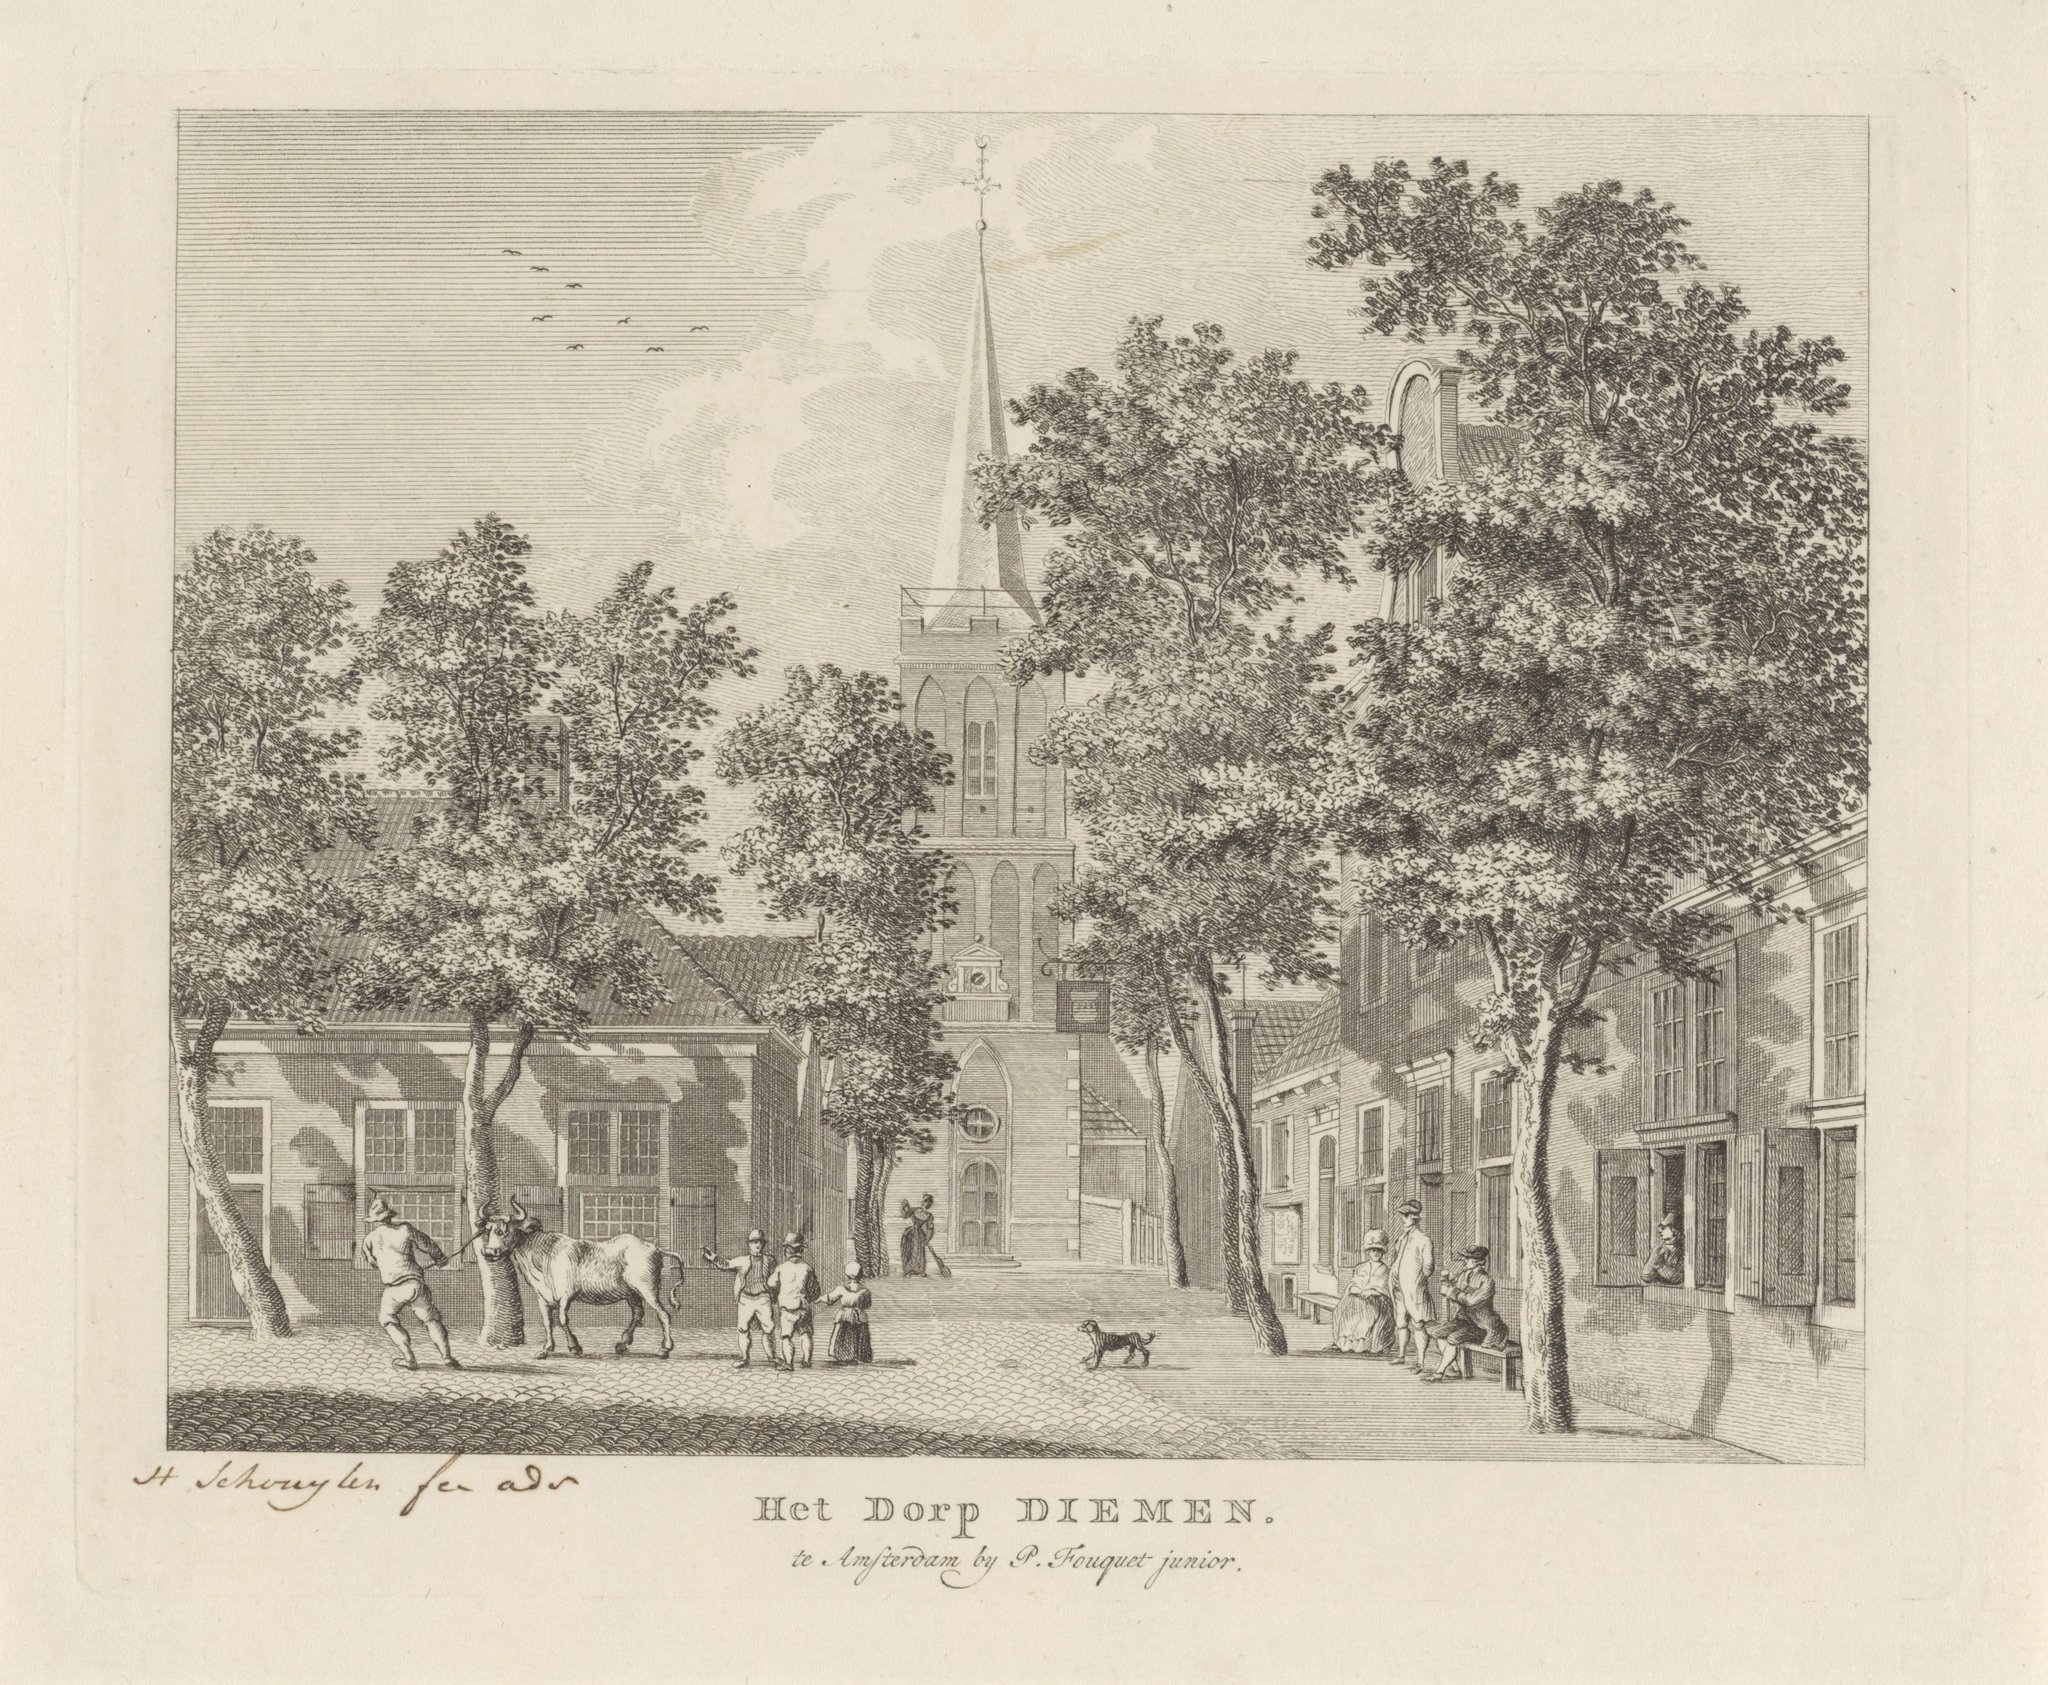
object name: print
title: Gezicht op Diemen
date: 1760-1796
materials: paper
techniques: etching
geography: amsterdam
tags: diemen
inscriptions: inscription: ‘H. Schouyten fec. ad v.’, collector's mark: Lugt 2228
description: Gezicht op de kerk in Diemen. Op straat trekt een man een rund voort. Een vrouw veegt het stoepje van de kerk schoon. Mannen en vrouwen maken een praatje op straat.